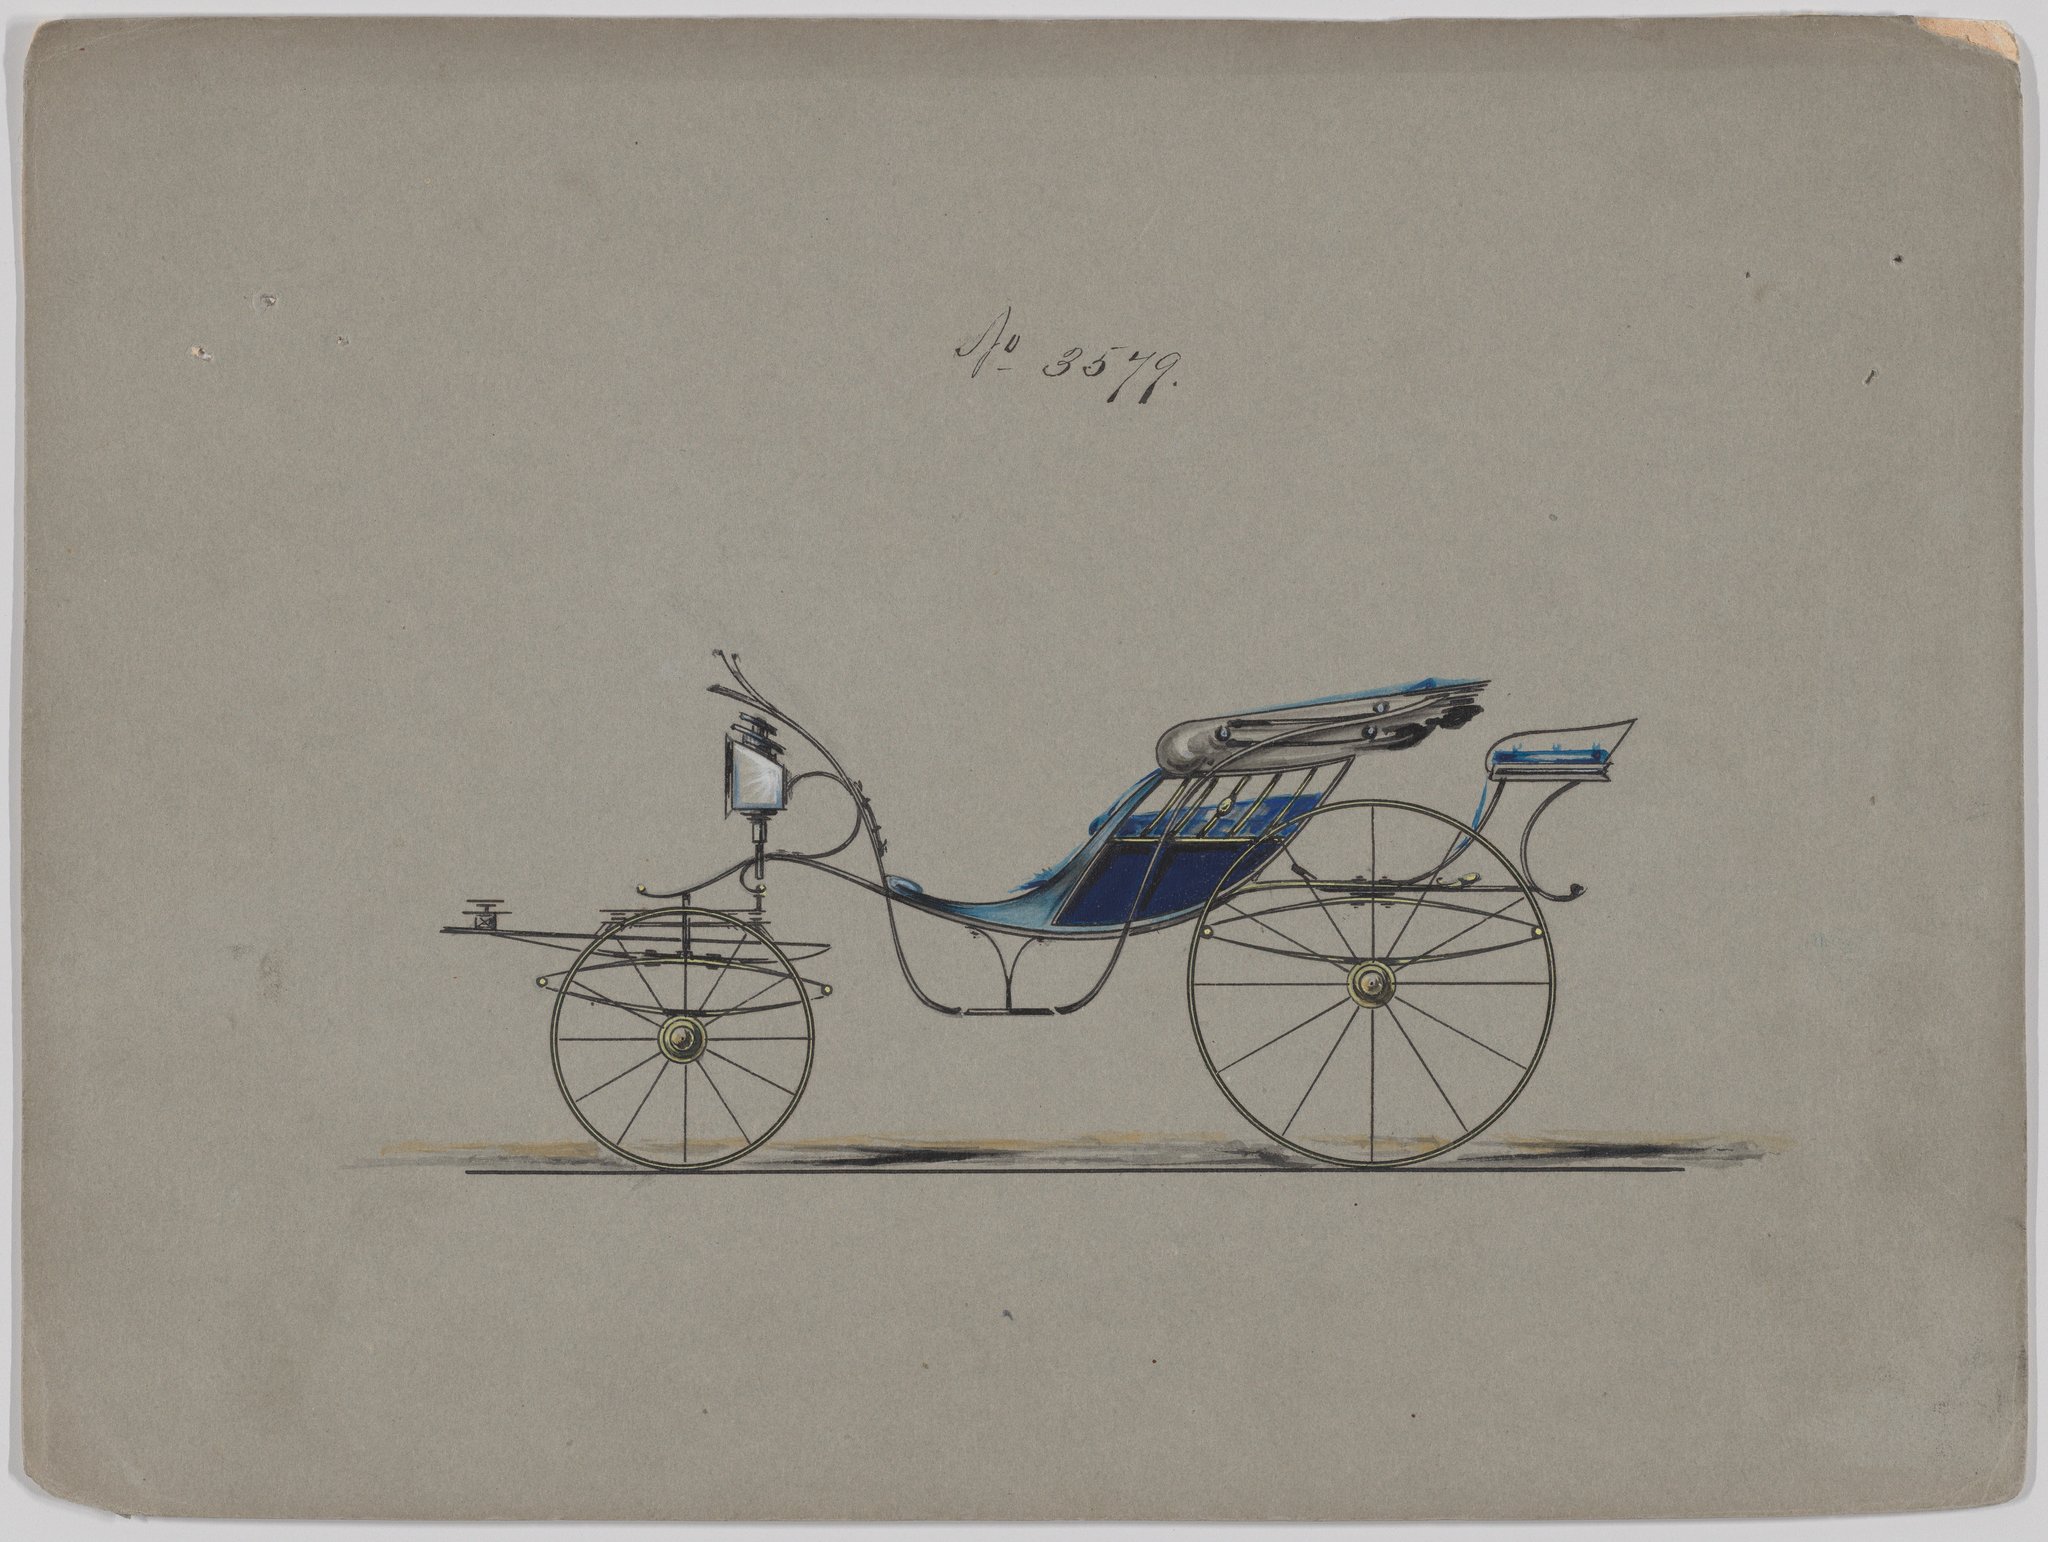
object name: drawing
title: Design for Pony Phaeton, no. 3579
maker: brewster & co.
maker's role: manufacturer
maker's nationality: american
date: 1880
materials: gouache, gum arabic, ink, watercolor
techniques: pen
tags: carriages